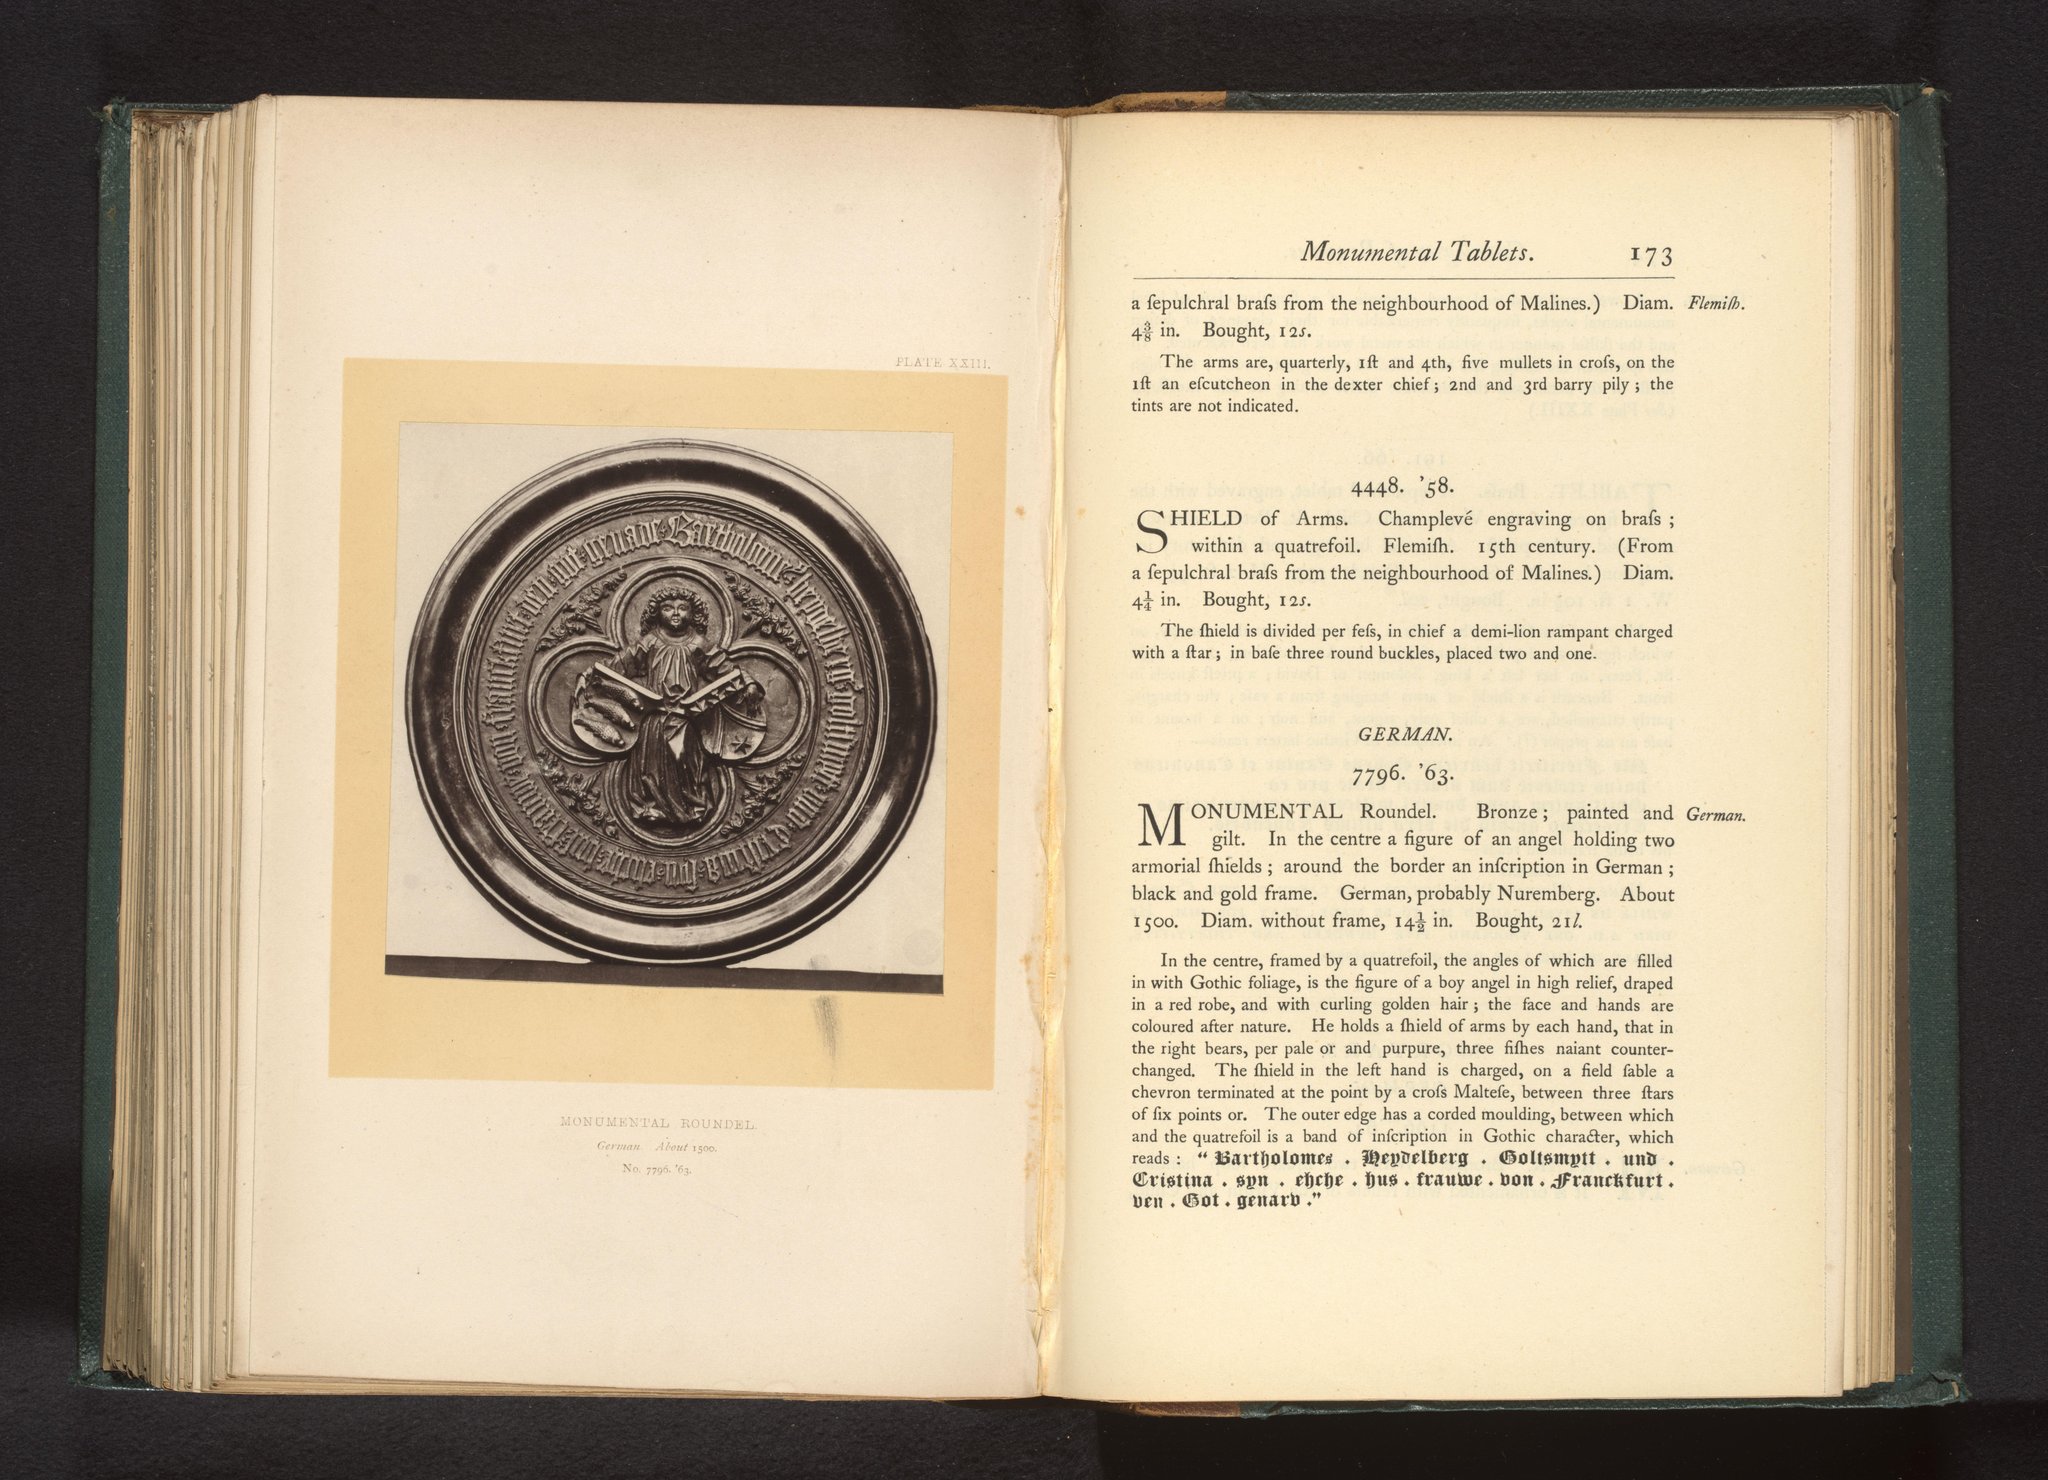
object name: page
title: Monumental roundel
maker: Anonymous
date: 1869-1876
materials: paper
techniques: woodburytype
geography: london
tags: ornament ~ circle and derived from circle, e.g.: guilloche, sculpture (+ relief ~ sculpture)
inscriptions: number: ‘No. 7796. '63.’, inscription: ‘German. About 1500.’, number: ‘Plate XXIII.’